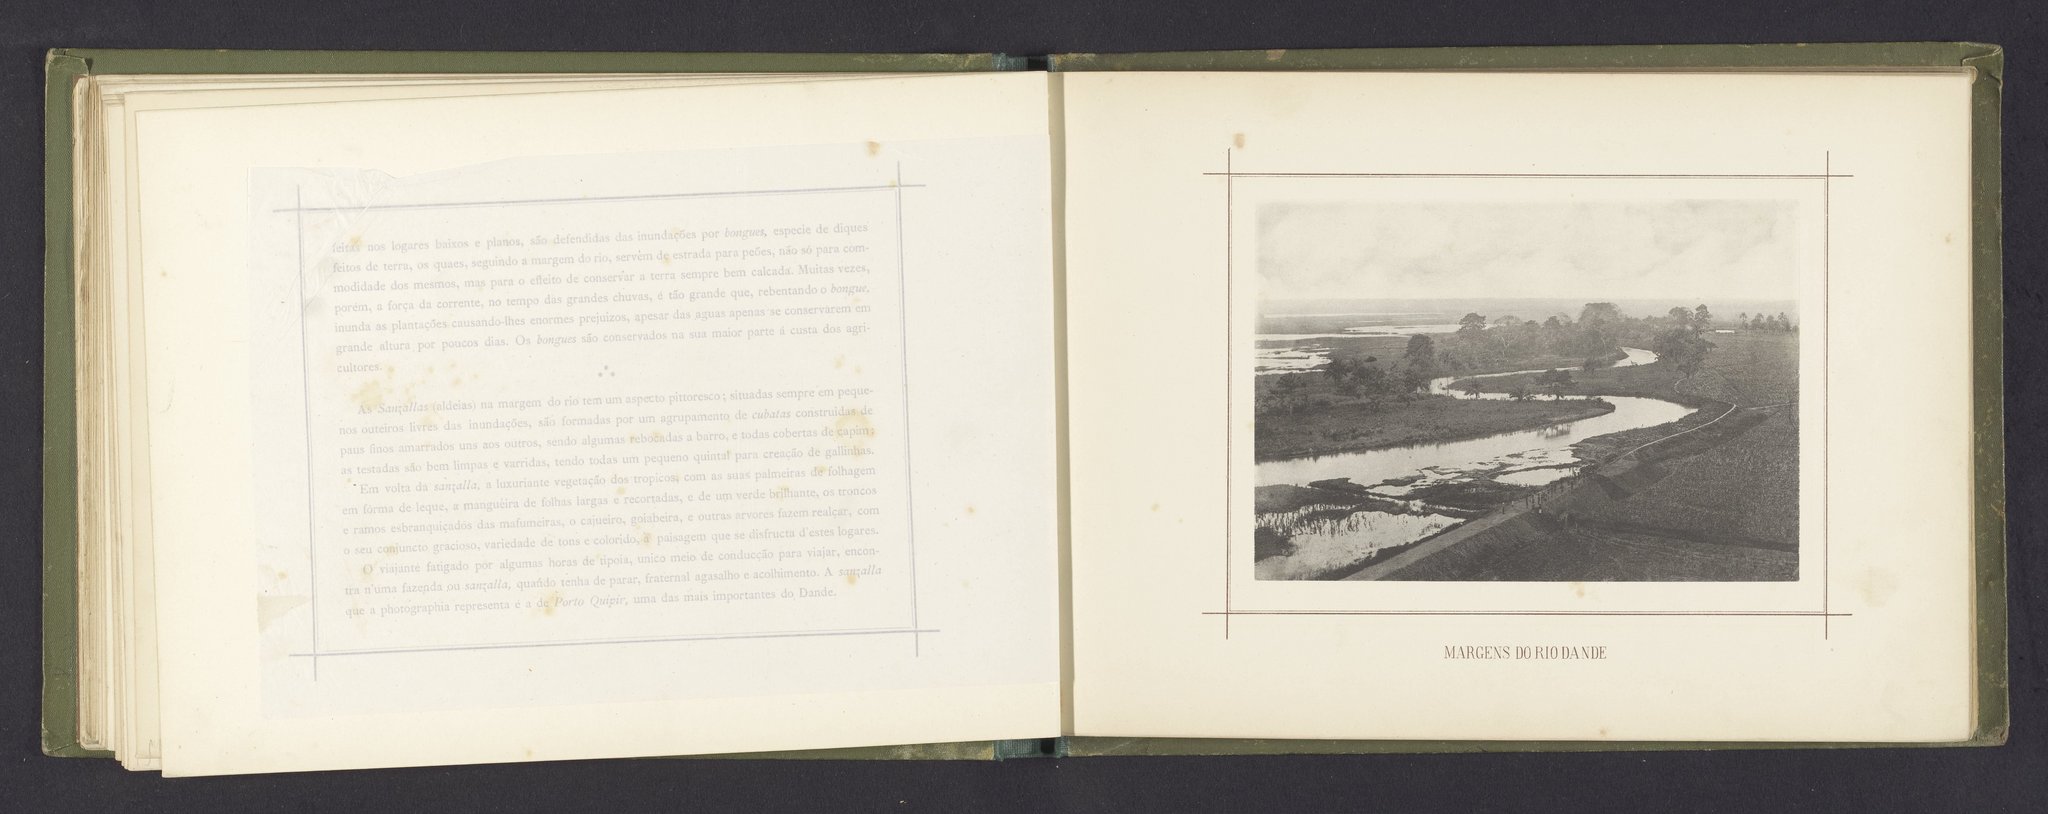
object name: photomechanical print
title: Margens do Rio Dande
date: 1876-1886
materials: paper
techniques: photograph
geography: angola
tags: river